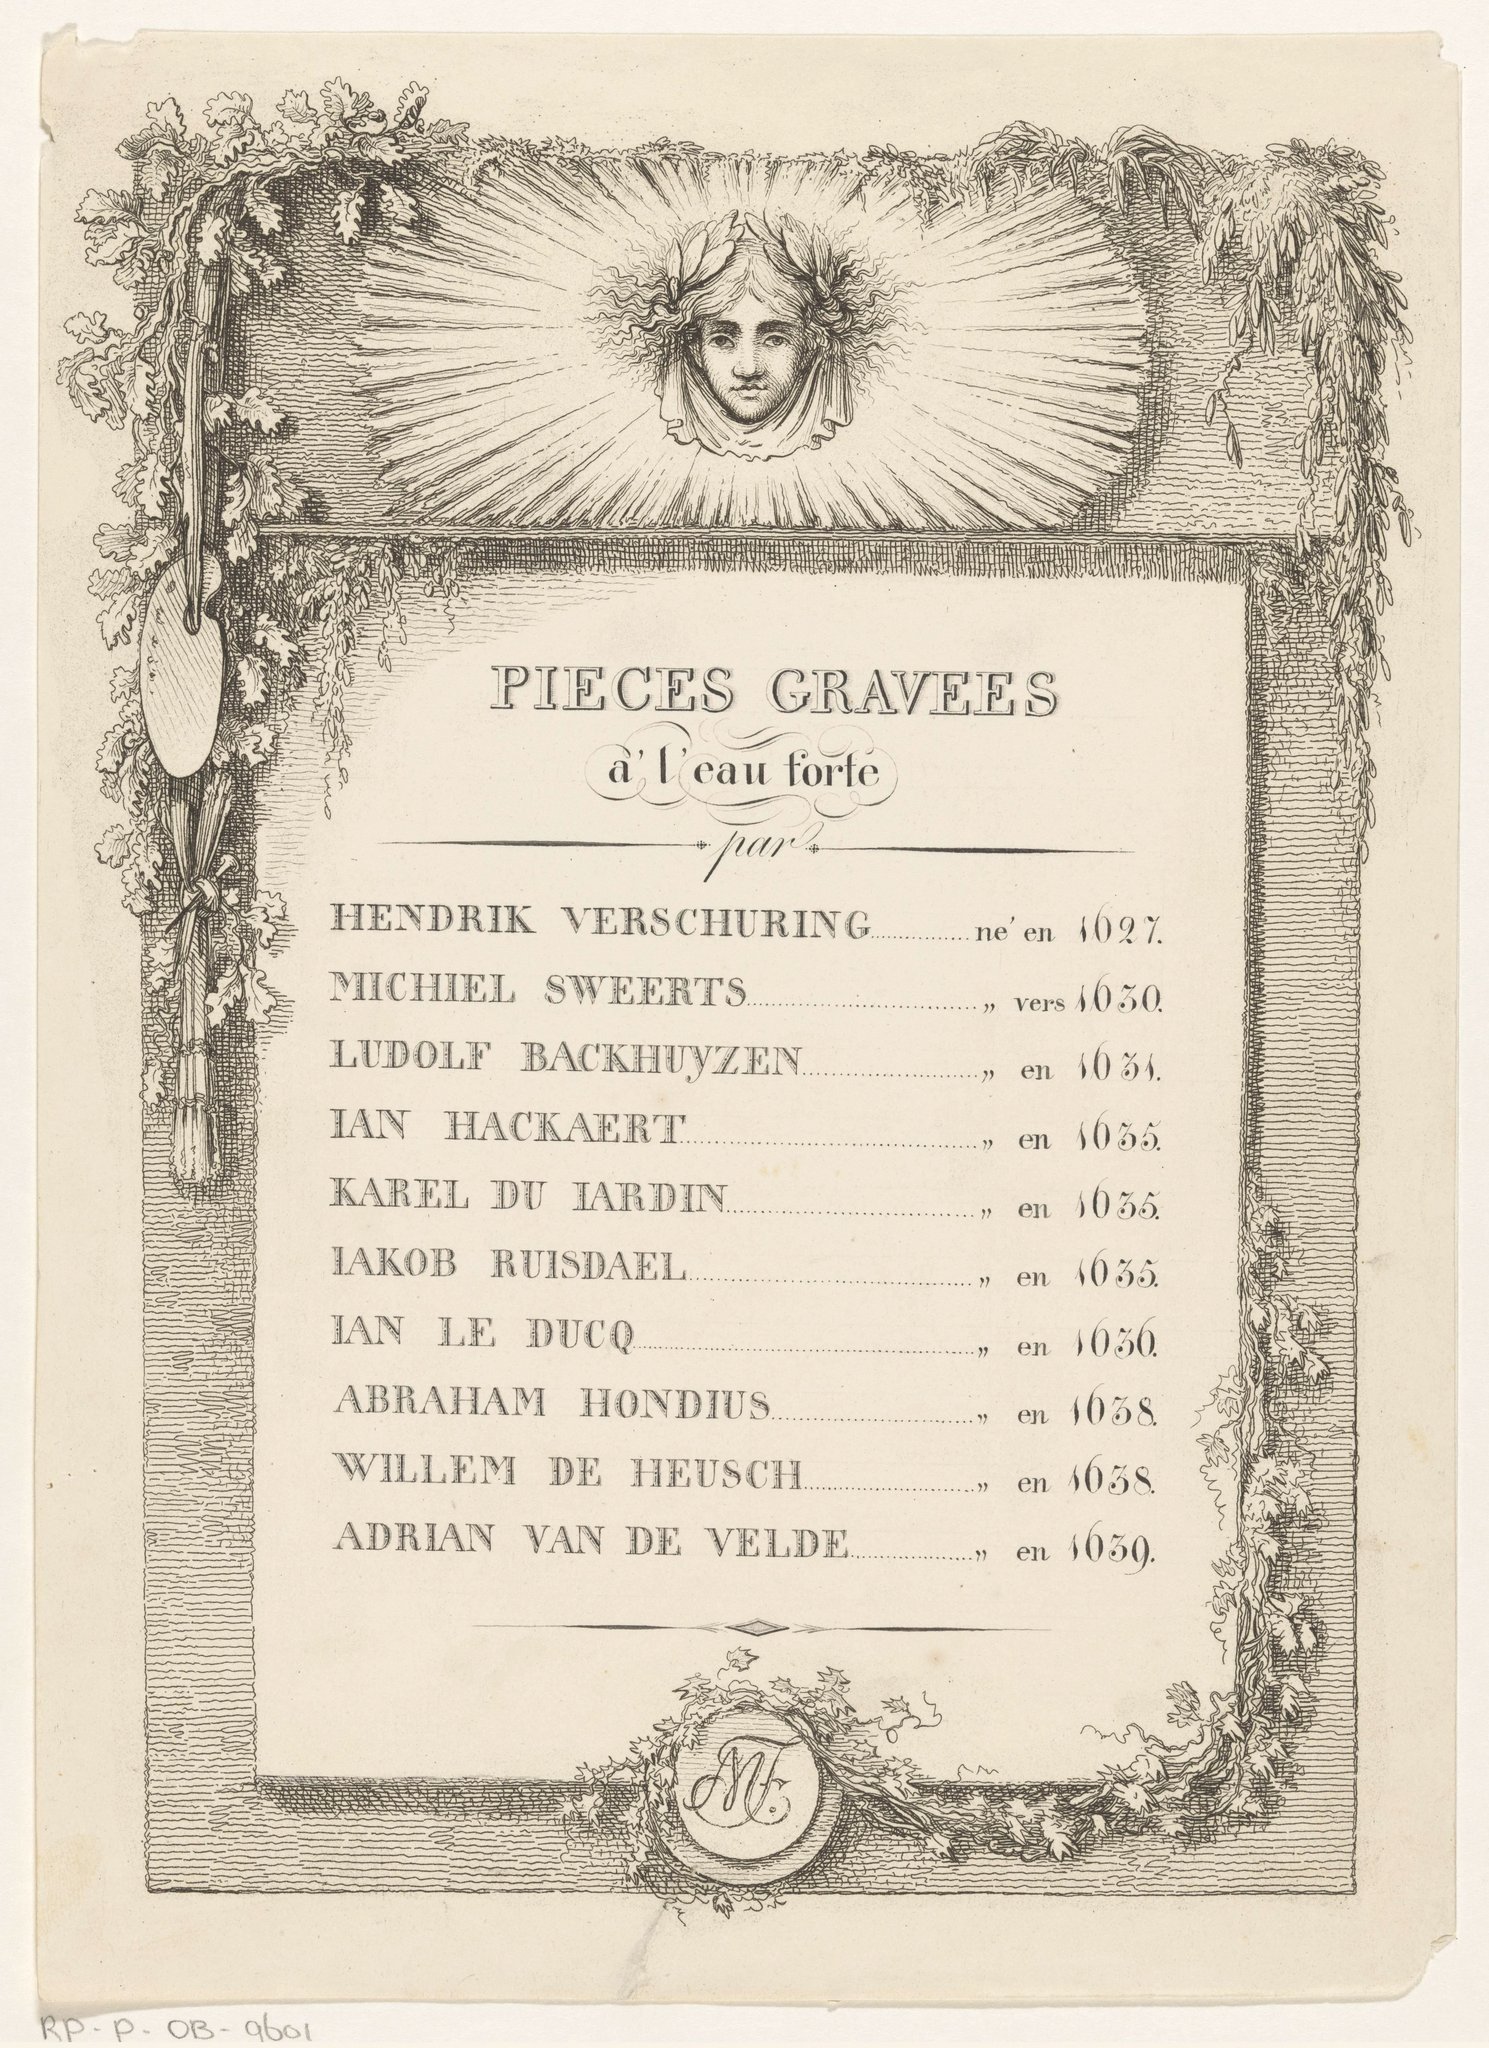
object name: print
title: Omlijsting met hoofd in stralenkrans en schilderspalet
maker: Anonymous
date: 1800-1899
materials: ink, paper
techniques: etching, pen, writing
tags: ornaments ~ art (+ framing decorations), palette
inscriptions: collector's mark: Lugt 2228, collector's mark: Lugt 2760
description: Omlijsting met bladmotieven, een schilderspalet, aan de bovenzijde een gelauwerd figuur in stralenkrans en aan de onderzijde de initialen MF. In het midden een geschreven tekst met opsomming van zeventiende-eeuwse kunstenaars.